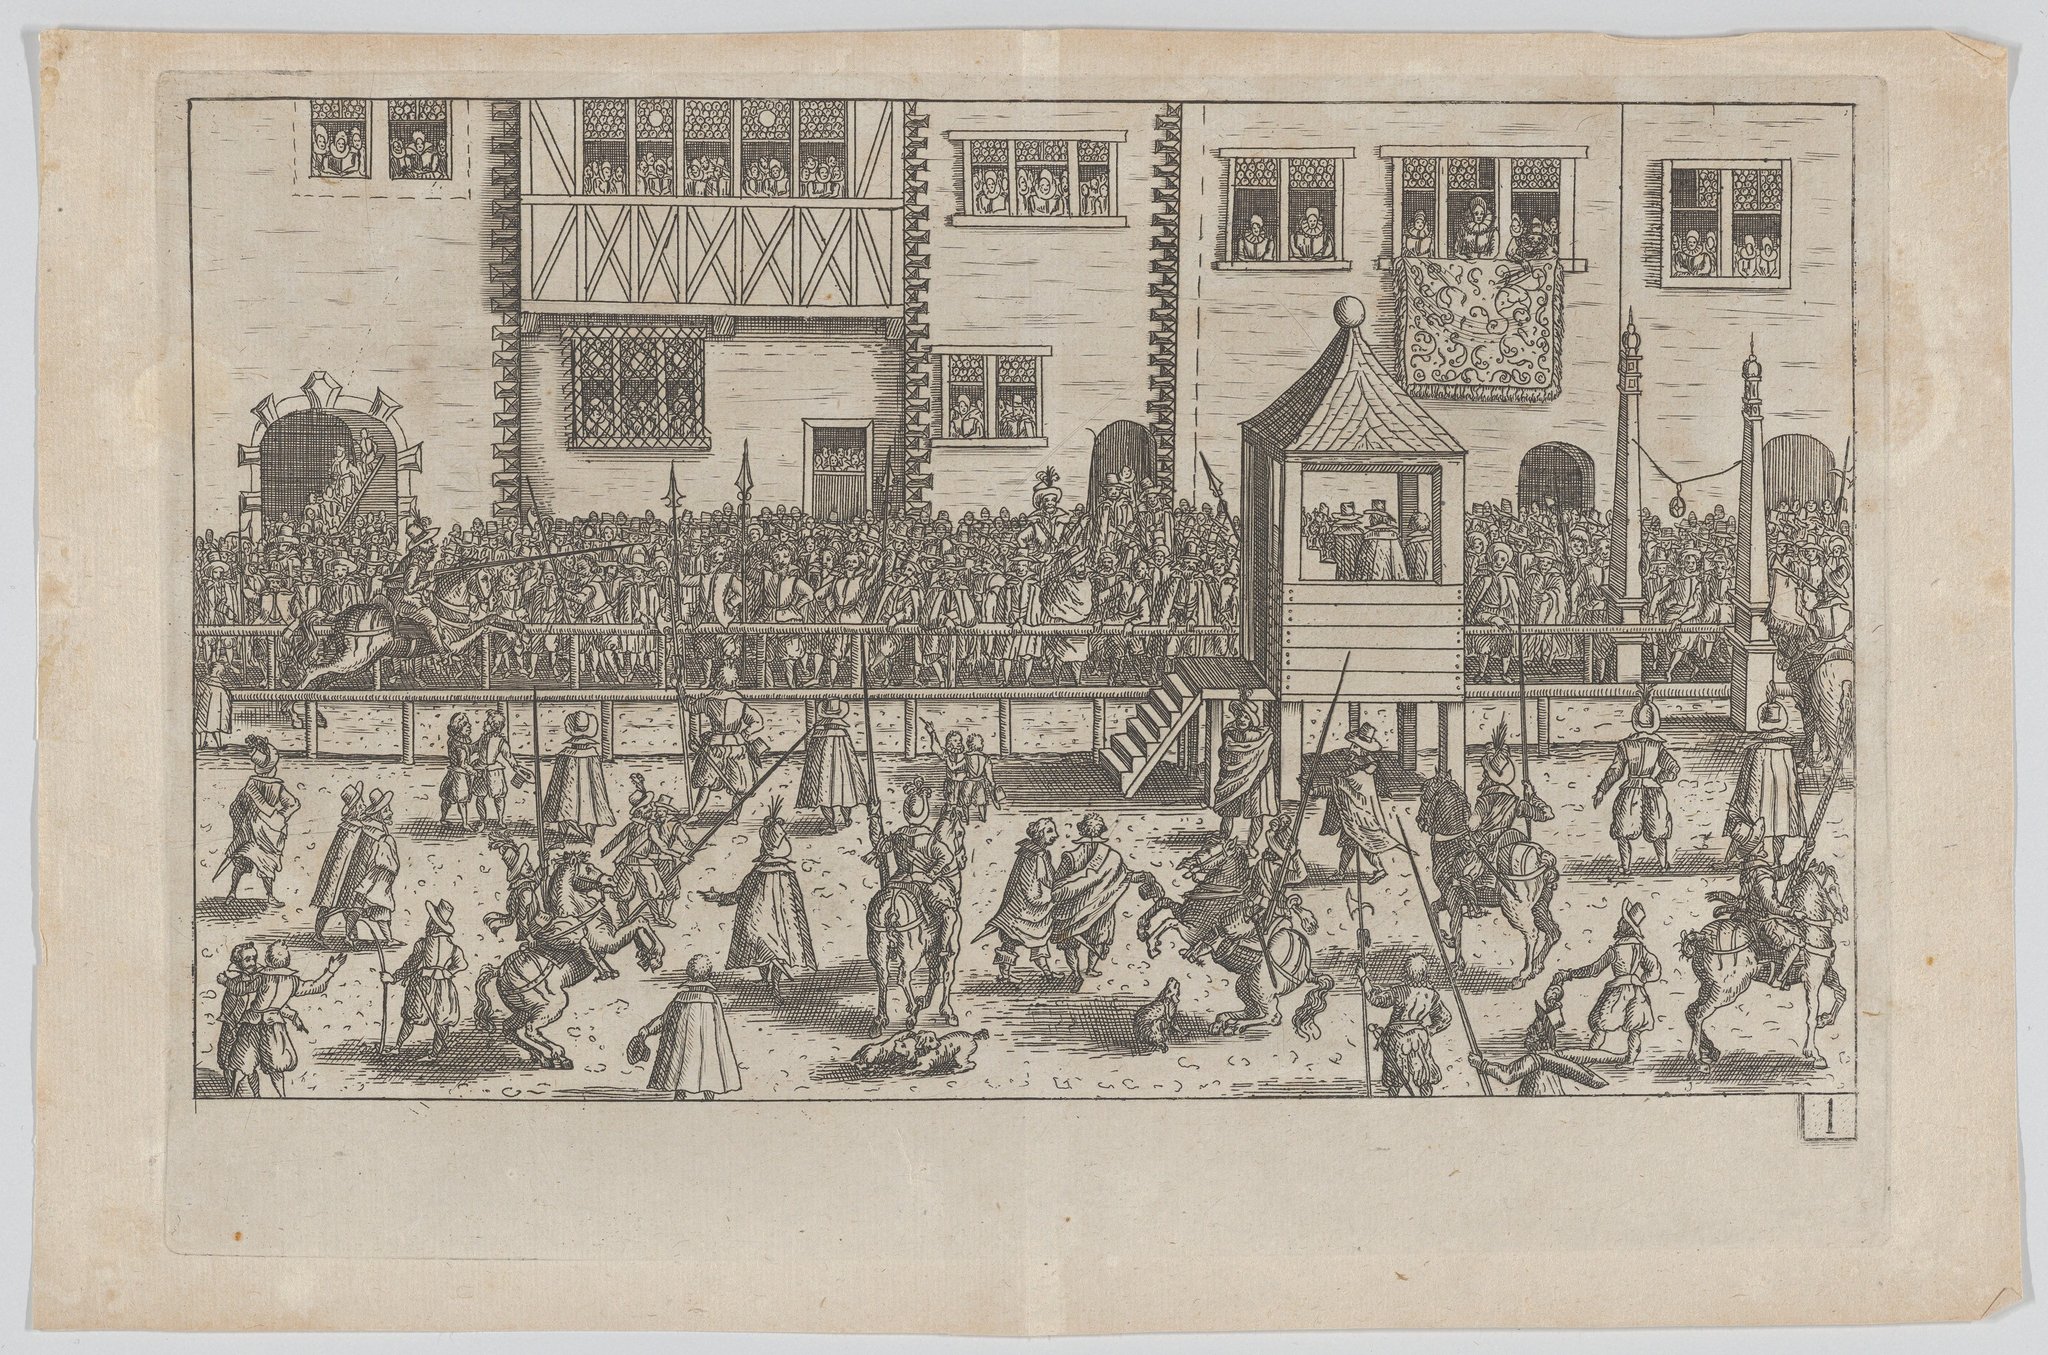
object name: print, fete, ornament architecture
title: Plate I: Election and Coronation of Emperor Maximilian II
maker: anonymous, german, 17th century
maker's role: publisher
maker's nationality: german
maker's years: 1600-1700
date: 1612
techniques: etching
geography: frankfurt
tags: elections,men,horses,crowd